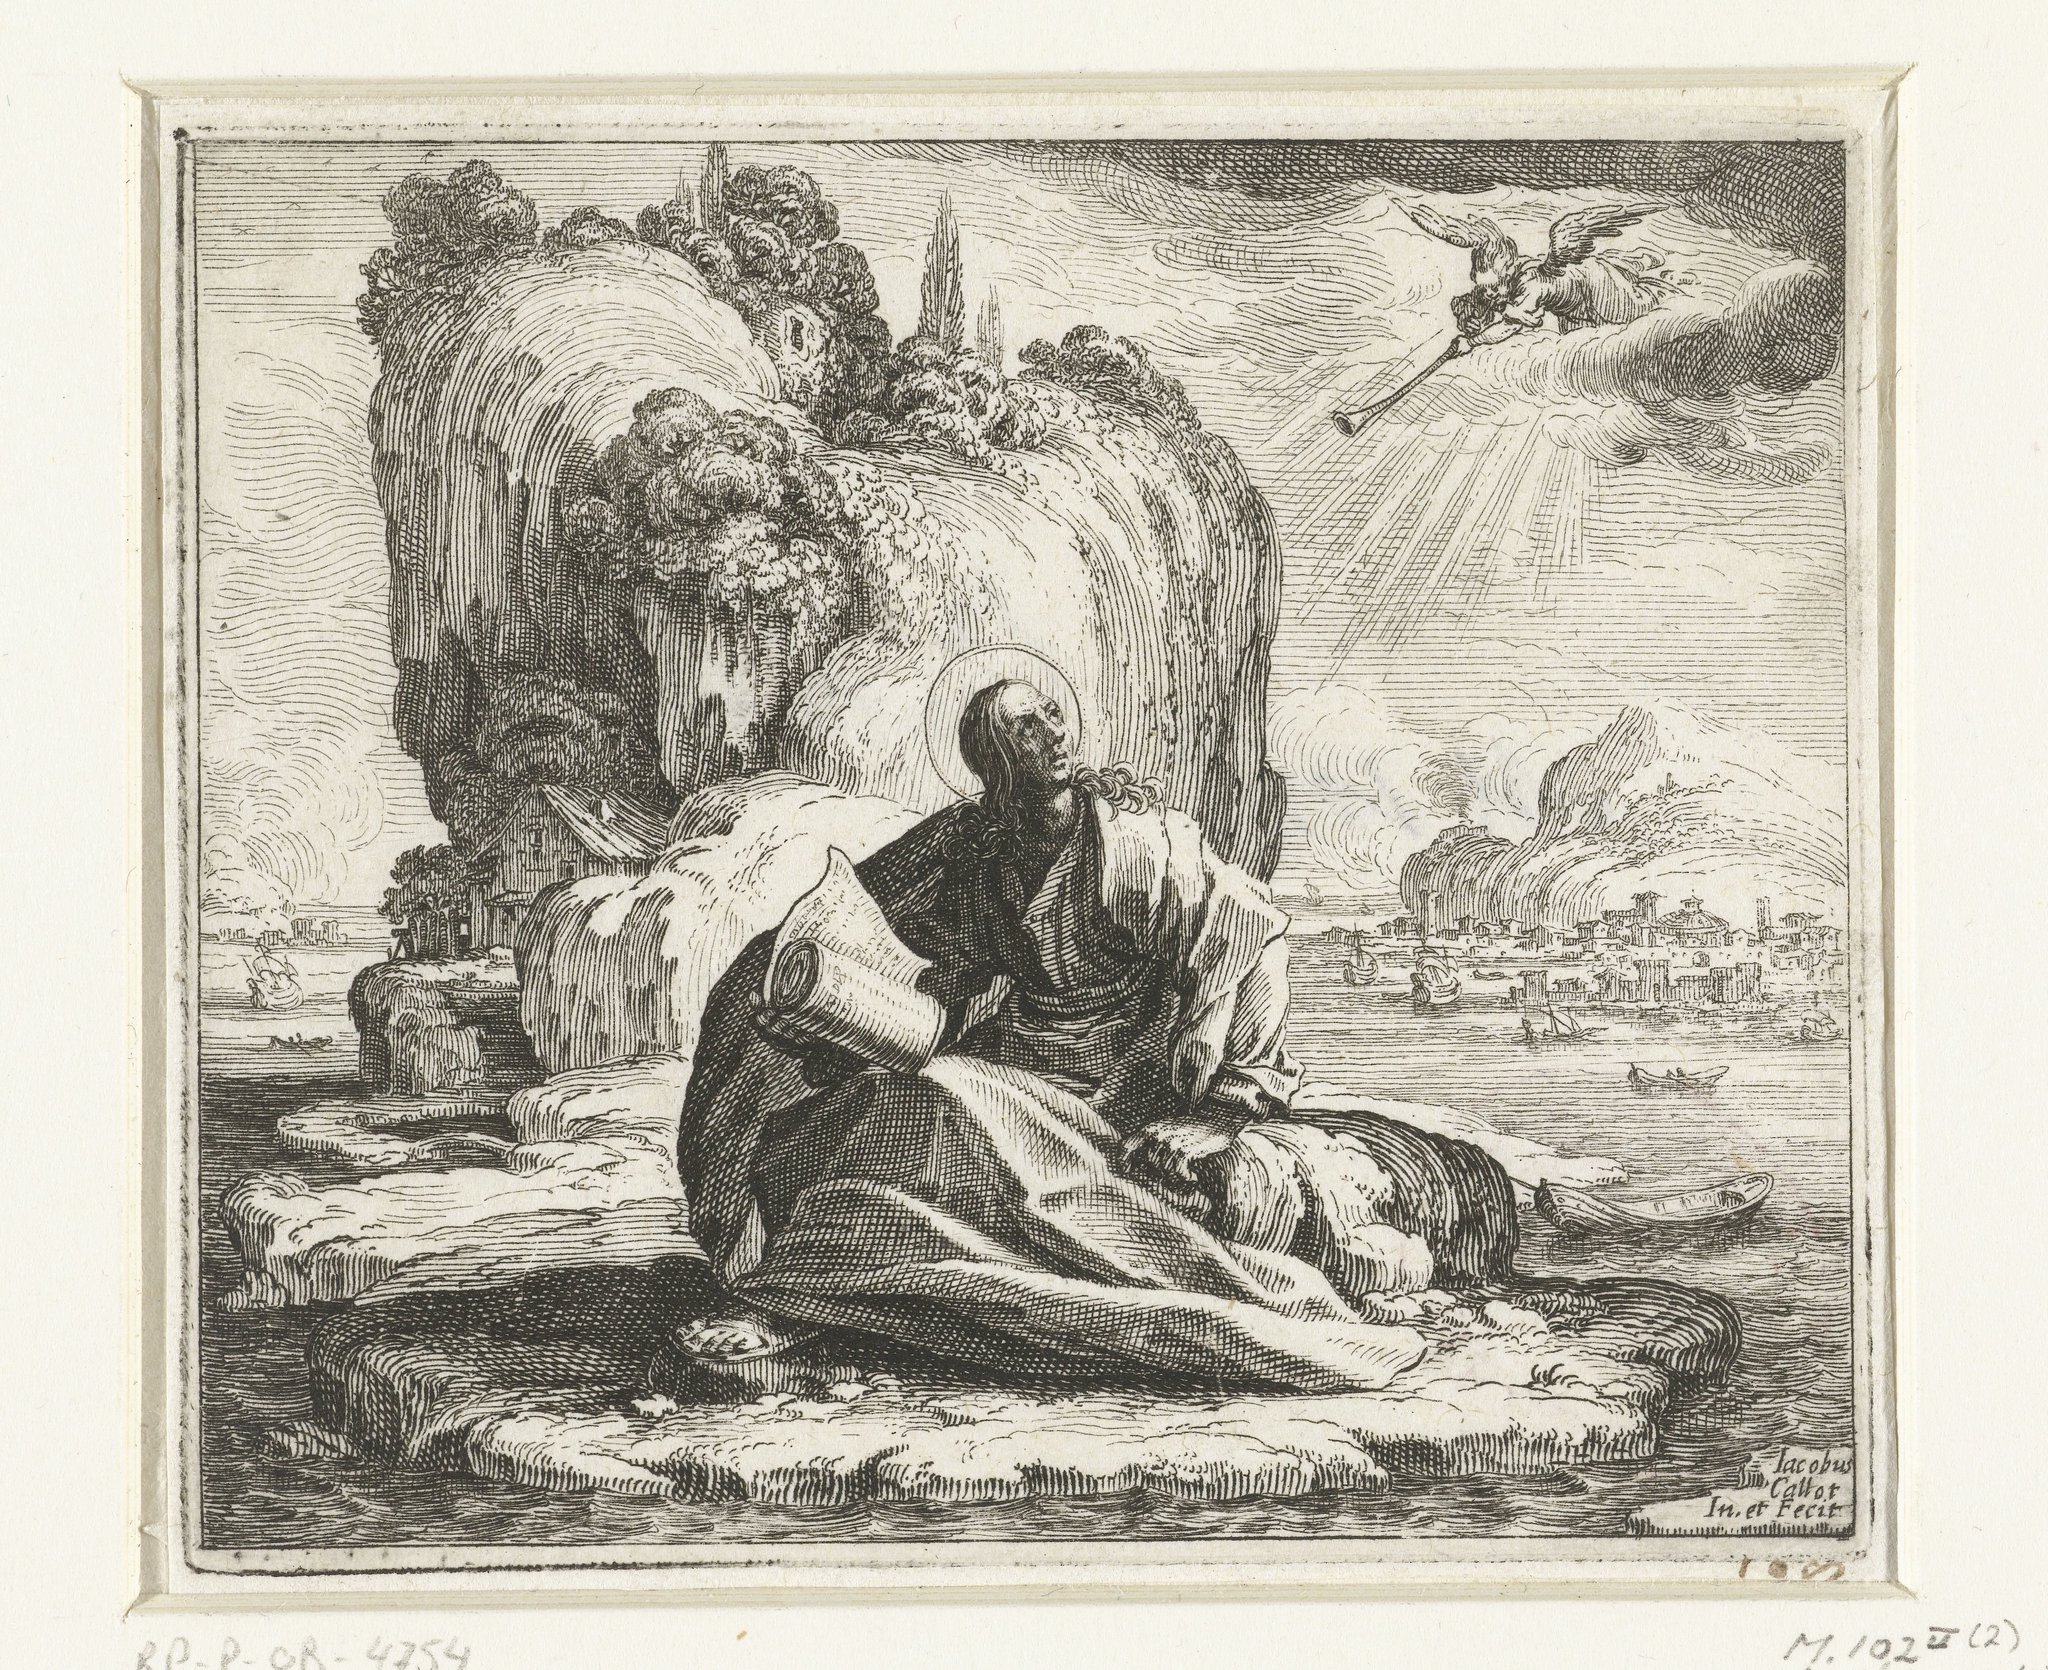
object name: print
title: Johannes de Evangelist op Patmos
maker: jacques callot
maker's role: draughtsman, print maker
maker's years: 1592-1635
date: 1621-1635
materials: paper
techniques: etching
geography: nancy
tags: the apostle john the evangelist; possible attributes: book, cauldron, chalice with snake, eagle, palm, scroll, an angel sent by christ appears to john on patmos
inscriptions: collector's mark: Lugt 240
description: Johannes de Evangelist zit op een eiland met een boekrol in de hand. Hij kijkt op naar een engel die op een bazuin blaast. Op de achtergrond een kustplaats.